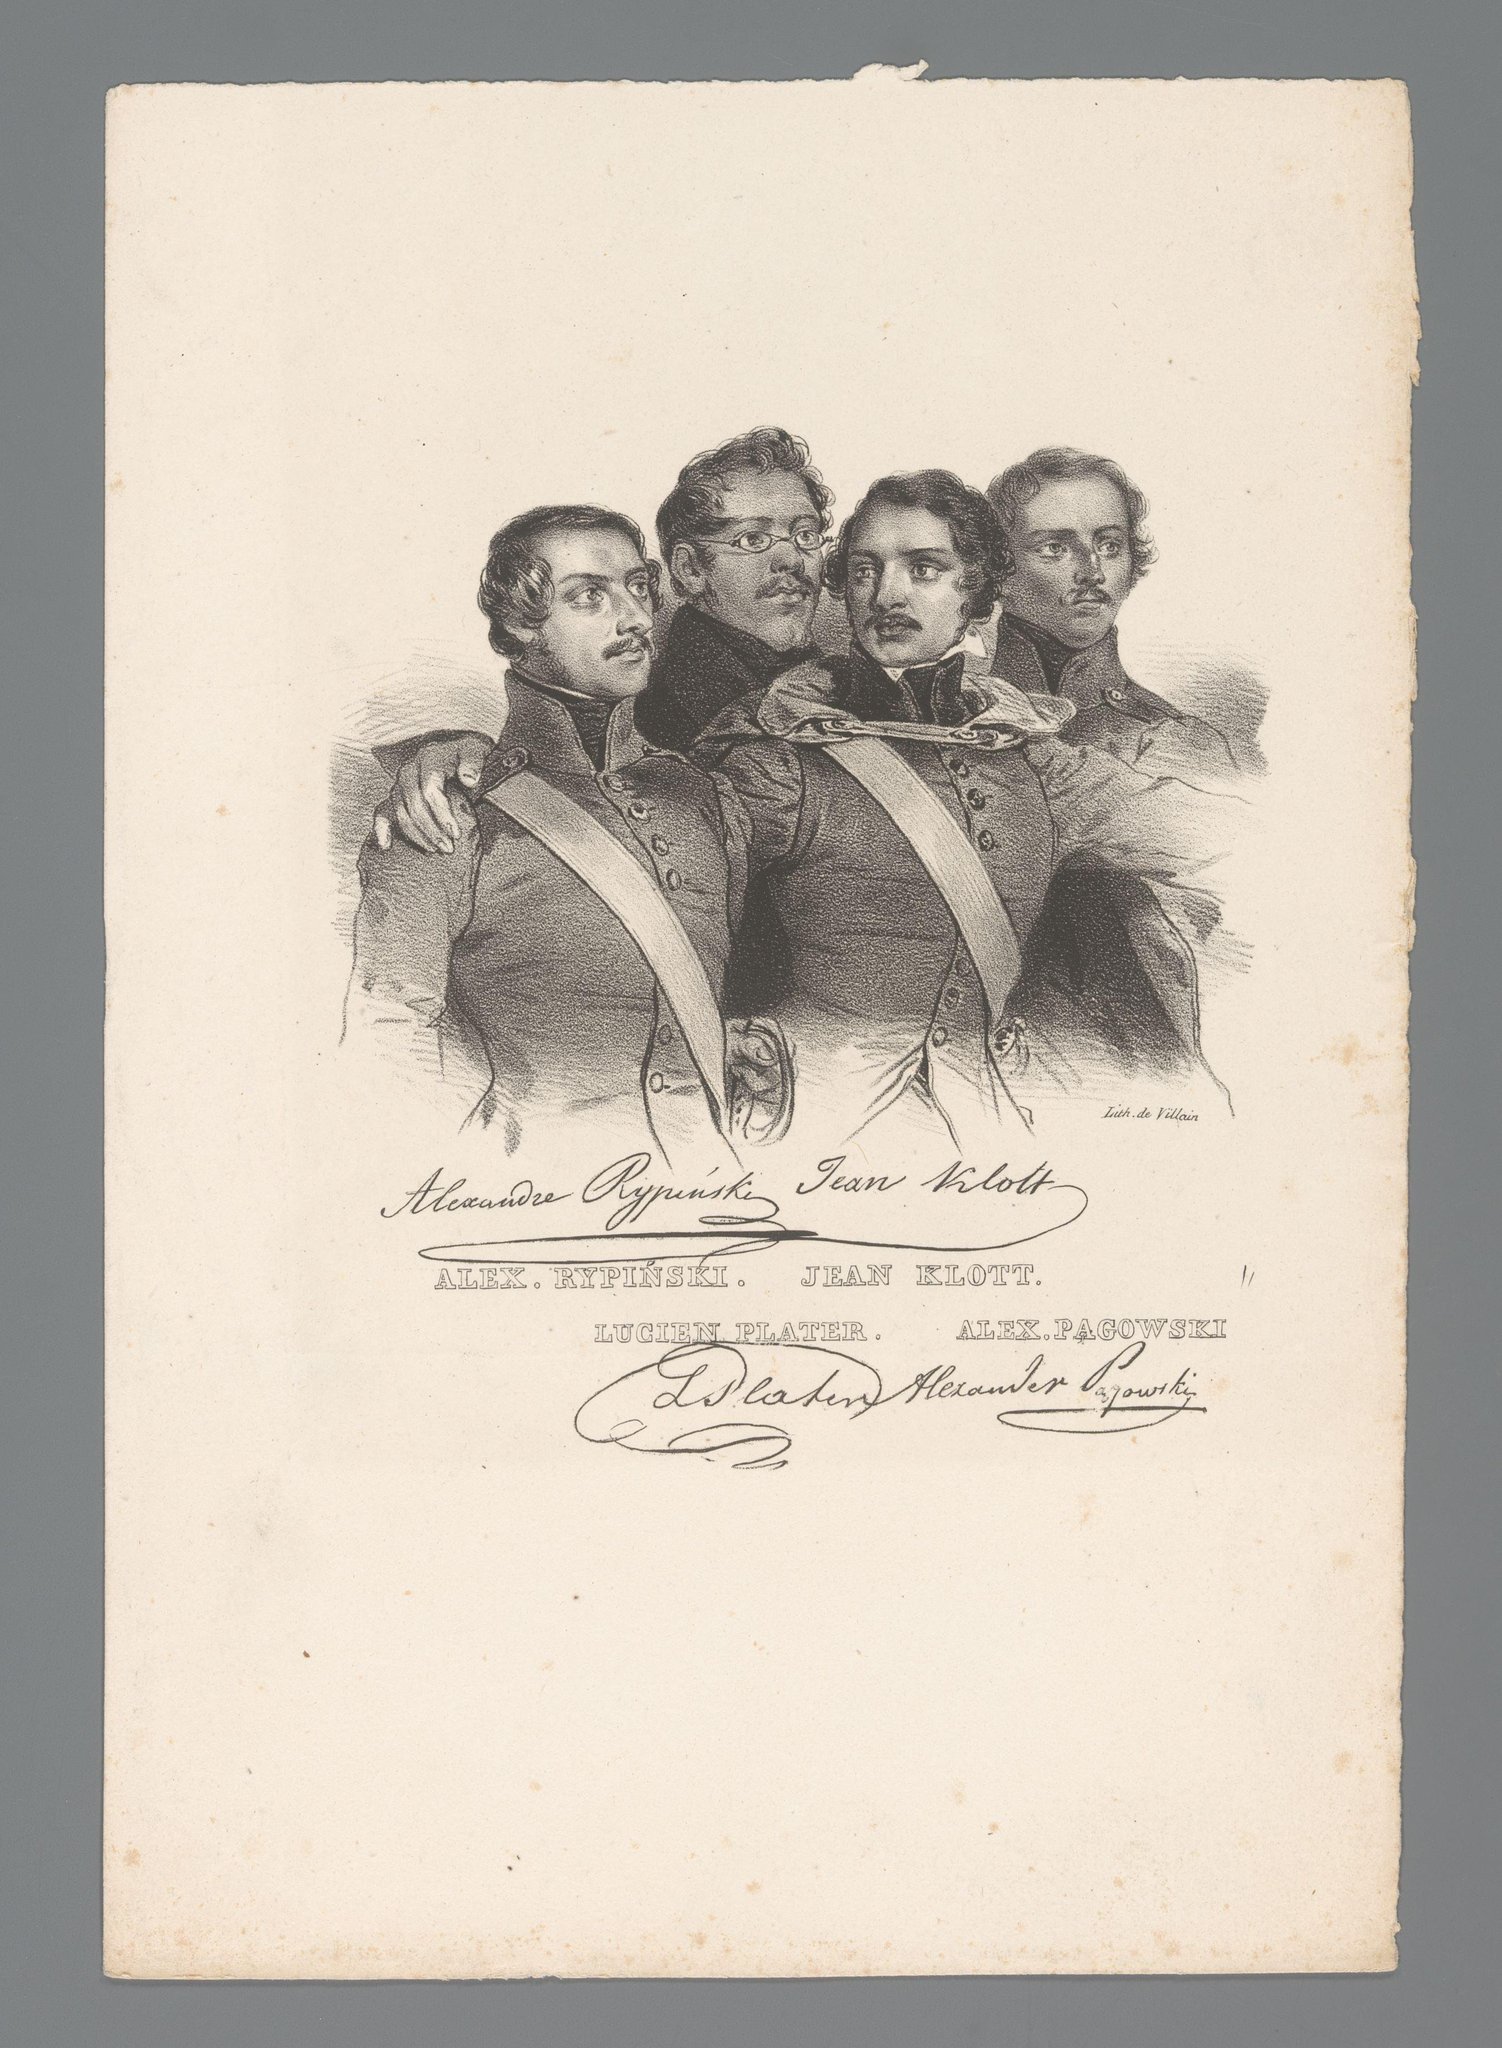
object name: book illustration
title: Alex. Rypinski. Jean Klott. Lucien Plater. Alex. Pagowski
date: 1832-1839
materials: paper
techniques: lithograph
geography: paris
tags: painter, historical persons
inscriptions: collector's mark: Lugt 2228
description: Prent uit: Straszewicz., Joseph. Les polonais et les polonaises de la révolution du 29 novembre 1830, ou Portraits des personnes qui ont figuré dans la dernière guerre de l'indépendance polonaise, avec les fac-simile de leur signature, lithographiés sur dessins originaux, par les artistes les plus distingués: MM. Grévedon, Maurin, Vigneron, Belliard, Devéria, Bazin, Desmadryl, Lecler, Desmaisons, Rutowski, officier polonais, etc,. etc., accompagnés d'une biographie pour chaque portrait. Parijs: Catherine-Anaïs Pinard, 1832. Of uit: Straszewicz., Joseph. Les polonais et les polonaises de la révolution du 29 novembre 1830. Biographie des personnes qui ont figuré dans la dernière guerre de l'indépendance polonaise, avec les fac-simile de leur signature, ornée de 30 portraits lithographiés sur dessins originaux, par les artistes les plus distingués: MM. Grévedon, Maurin, Vigneron, Belliard, Devéria, Bazin, Desmadryl, Lecler, etc., etc.. Parijs: s.n., 1839.